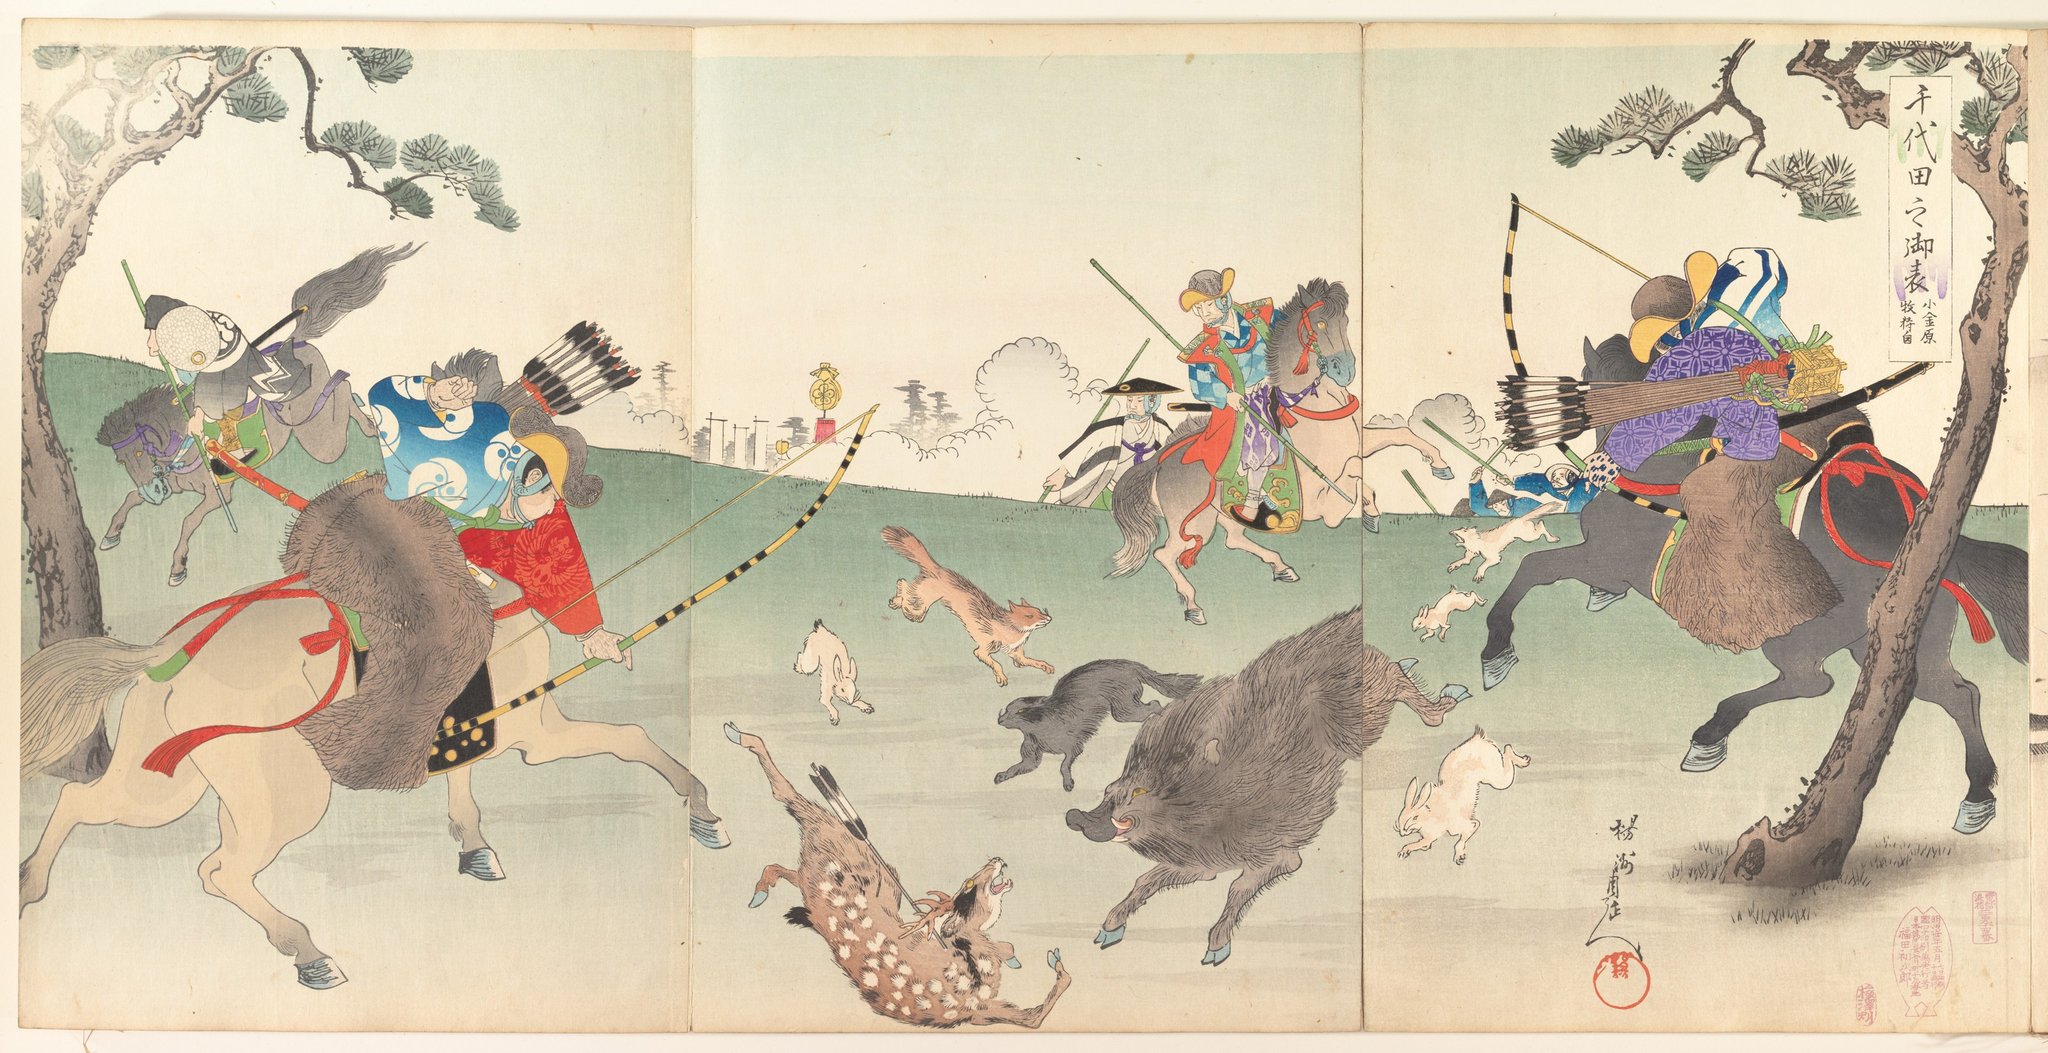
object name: print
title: Chiyoda Castle (Album of Men)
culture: japanese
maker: yōshū (hashimoto) chikanobu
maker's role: artist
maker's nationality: japanese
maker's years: 1838-1912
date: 1897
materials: ink, paper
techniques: woodblock print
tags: animals,hunting,horses